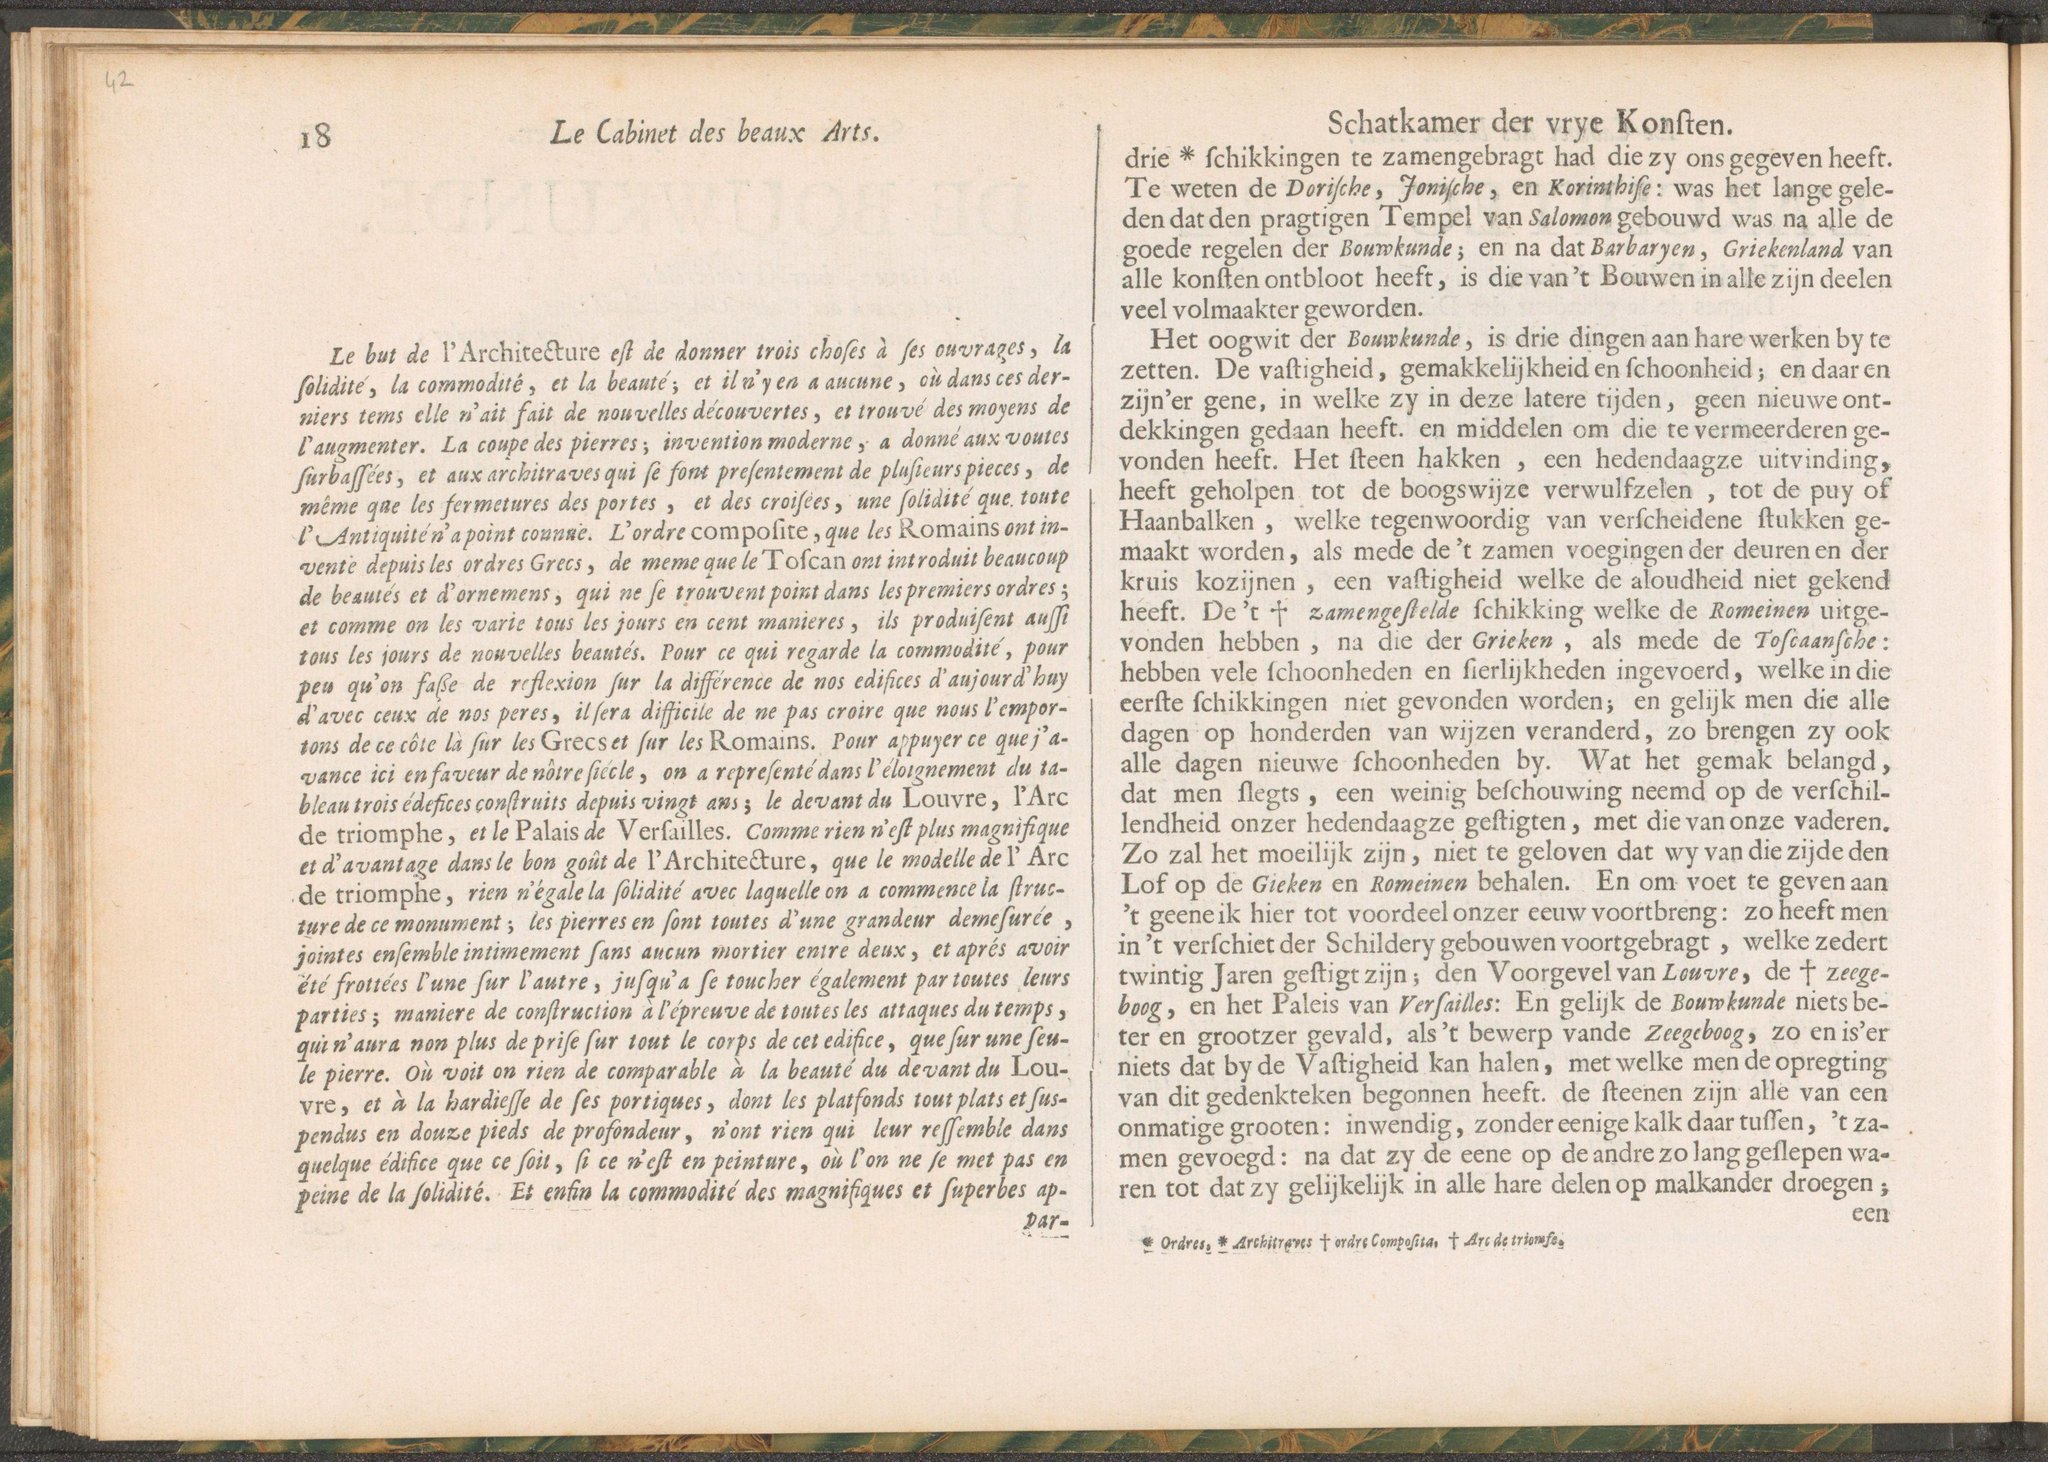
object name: text sheet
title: Tekstblad over de Architectuur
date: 1693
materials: paper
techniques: letterpress printing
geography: amsterdam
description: Verklaring van de prent met de voorstelling van de personificatie van Architectuur in het Frans en het Nederlands, pagina 18. Tekstblad maakt deel uit van een album.